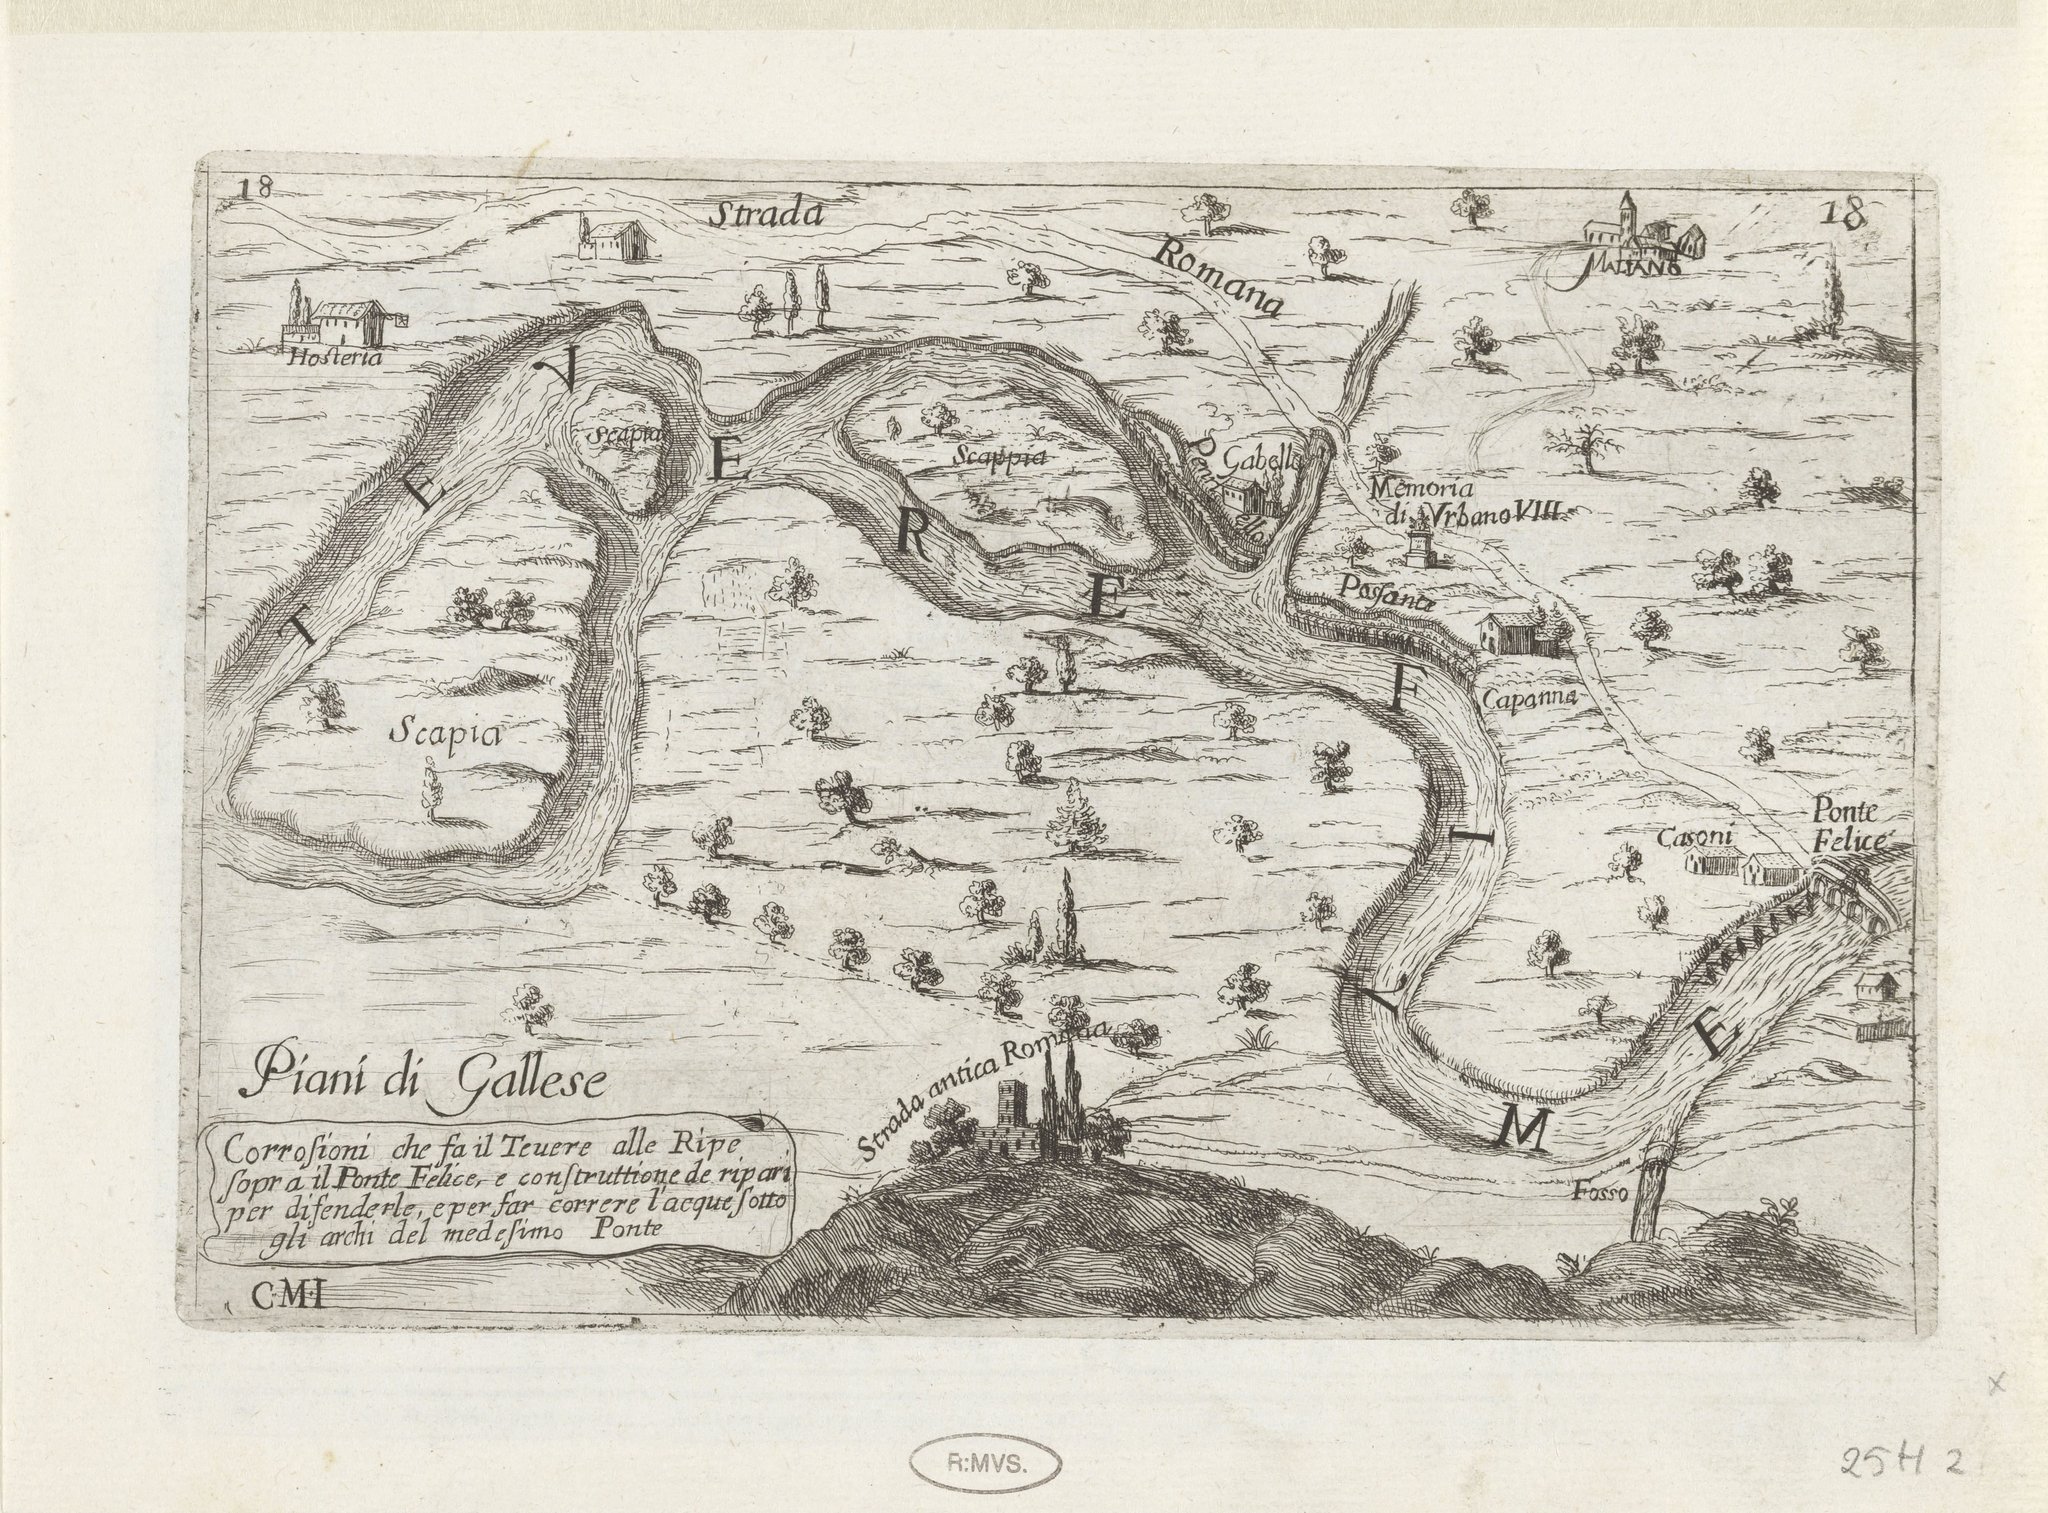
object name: print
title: Kaart met loop van de Tiber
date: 1677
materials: paper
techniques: etching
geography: italy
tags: river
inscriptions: collector's mark: Lugt 2228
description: Deze prent maakte oorspronkelijk deel uit van een publicatie bestaande uit drie delen, uitgegeven door G.G. Komarek in Rome in 1696. Het eerste deel zit achter een titelpagina met de titel: L'arte di rendere i fiumi navigabili, in varij modi, con altre nuove inventioni, e varij altri segreti. Deel twee zit achter een titelpagina met de titel: Racolta di varii segreti come si vedono nelle segventi figure. Deel drie zit achter een titelpagina met de titel: Osservazioni delle comete che dovranno seguire, e dell'ecclisse del primo satellite di Giove, et altre propositioni prosicue da farsi per commodo & ornamento della città. Deze prent komt uit het eerste deel. Prenten in de publicatie zijn naar ontwerp van Cornelis Meijer gemaakt door verschillende prentmakers, onder wie G.B. Falda, G. van Wittel, Gomar Wouters, etc. Er is ook een eerdere versie bekend van deze publicatie, uitgegeven in Rome in 1683, met de titel: L'arte di restituire a Roma la tralasciata navigazione del suo Tevere.